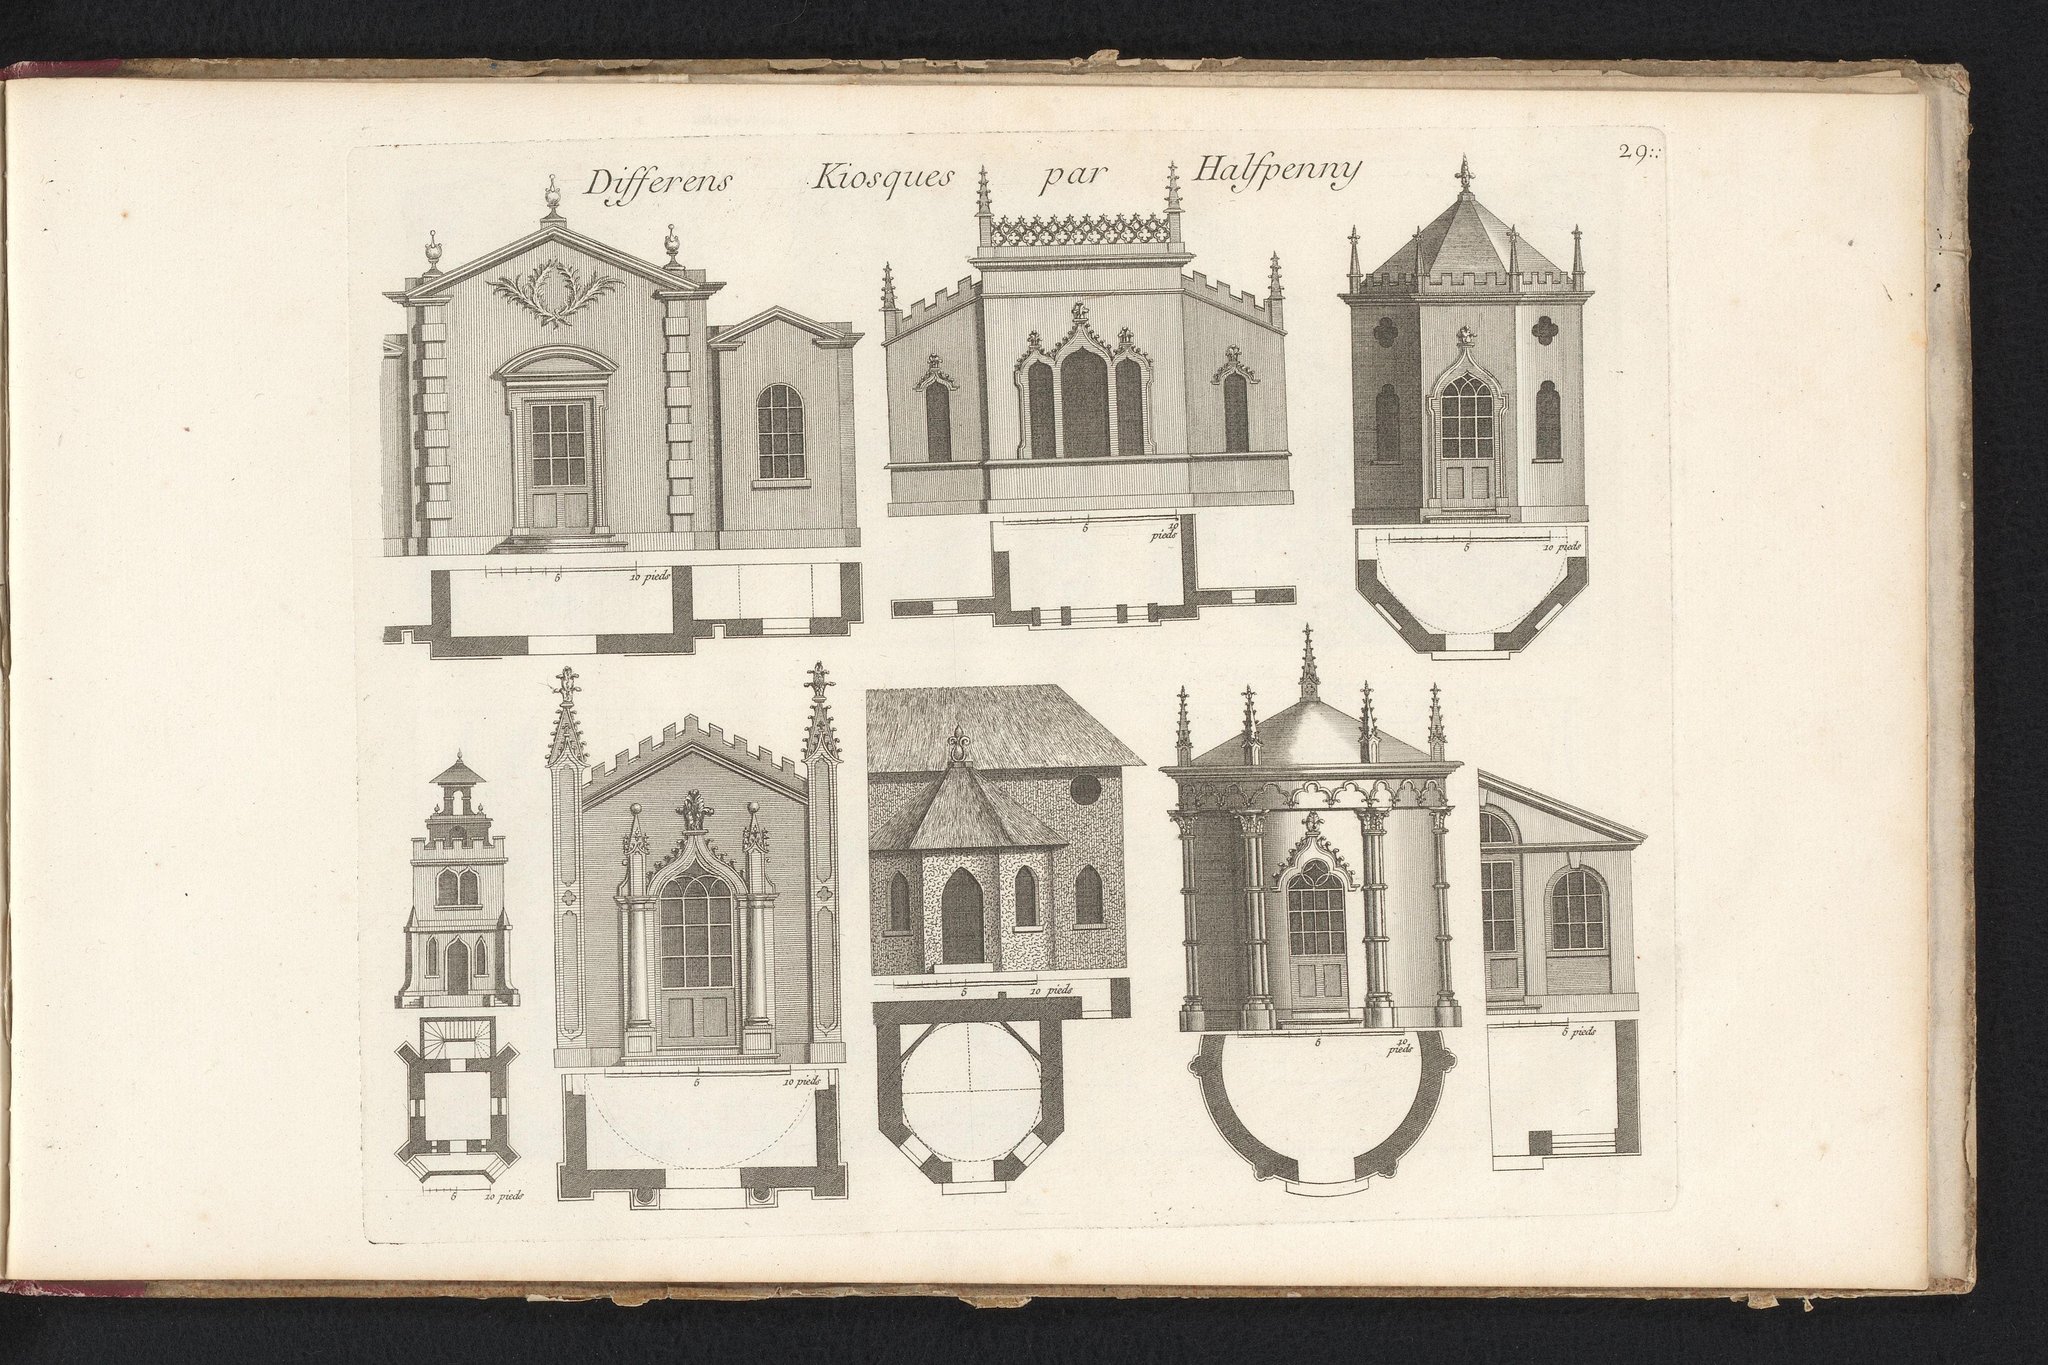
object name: print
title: Landschapstuinen in Chinees-Engelse stijl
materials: paper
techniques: engraving, etching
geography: paris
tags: garden buildings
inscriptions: collector's mark: Lugt 2228, collector's mark: Lugt 2760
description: De serie 'Jardins anglo-chinois à la mode' verscheen in totaal in 21 zogeheten 'cahiers' (afleveringen). De huidige prent komt uit het vierde 'cahier'. Het Rijksmuseum Amsterdam bezit drie banden met daarin in totaal zes 'cahiers' van deze reeks. In de documentatie wordt verwezen naar een in de bibliotheek van het Rijksmuseum Amsterdam aanwezige facsimile van het complete werk.